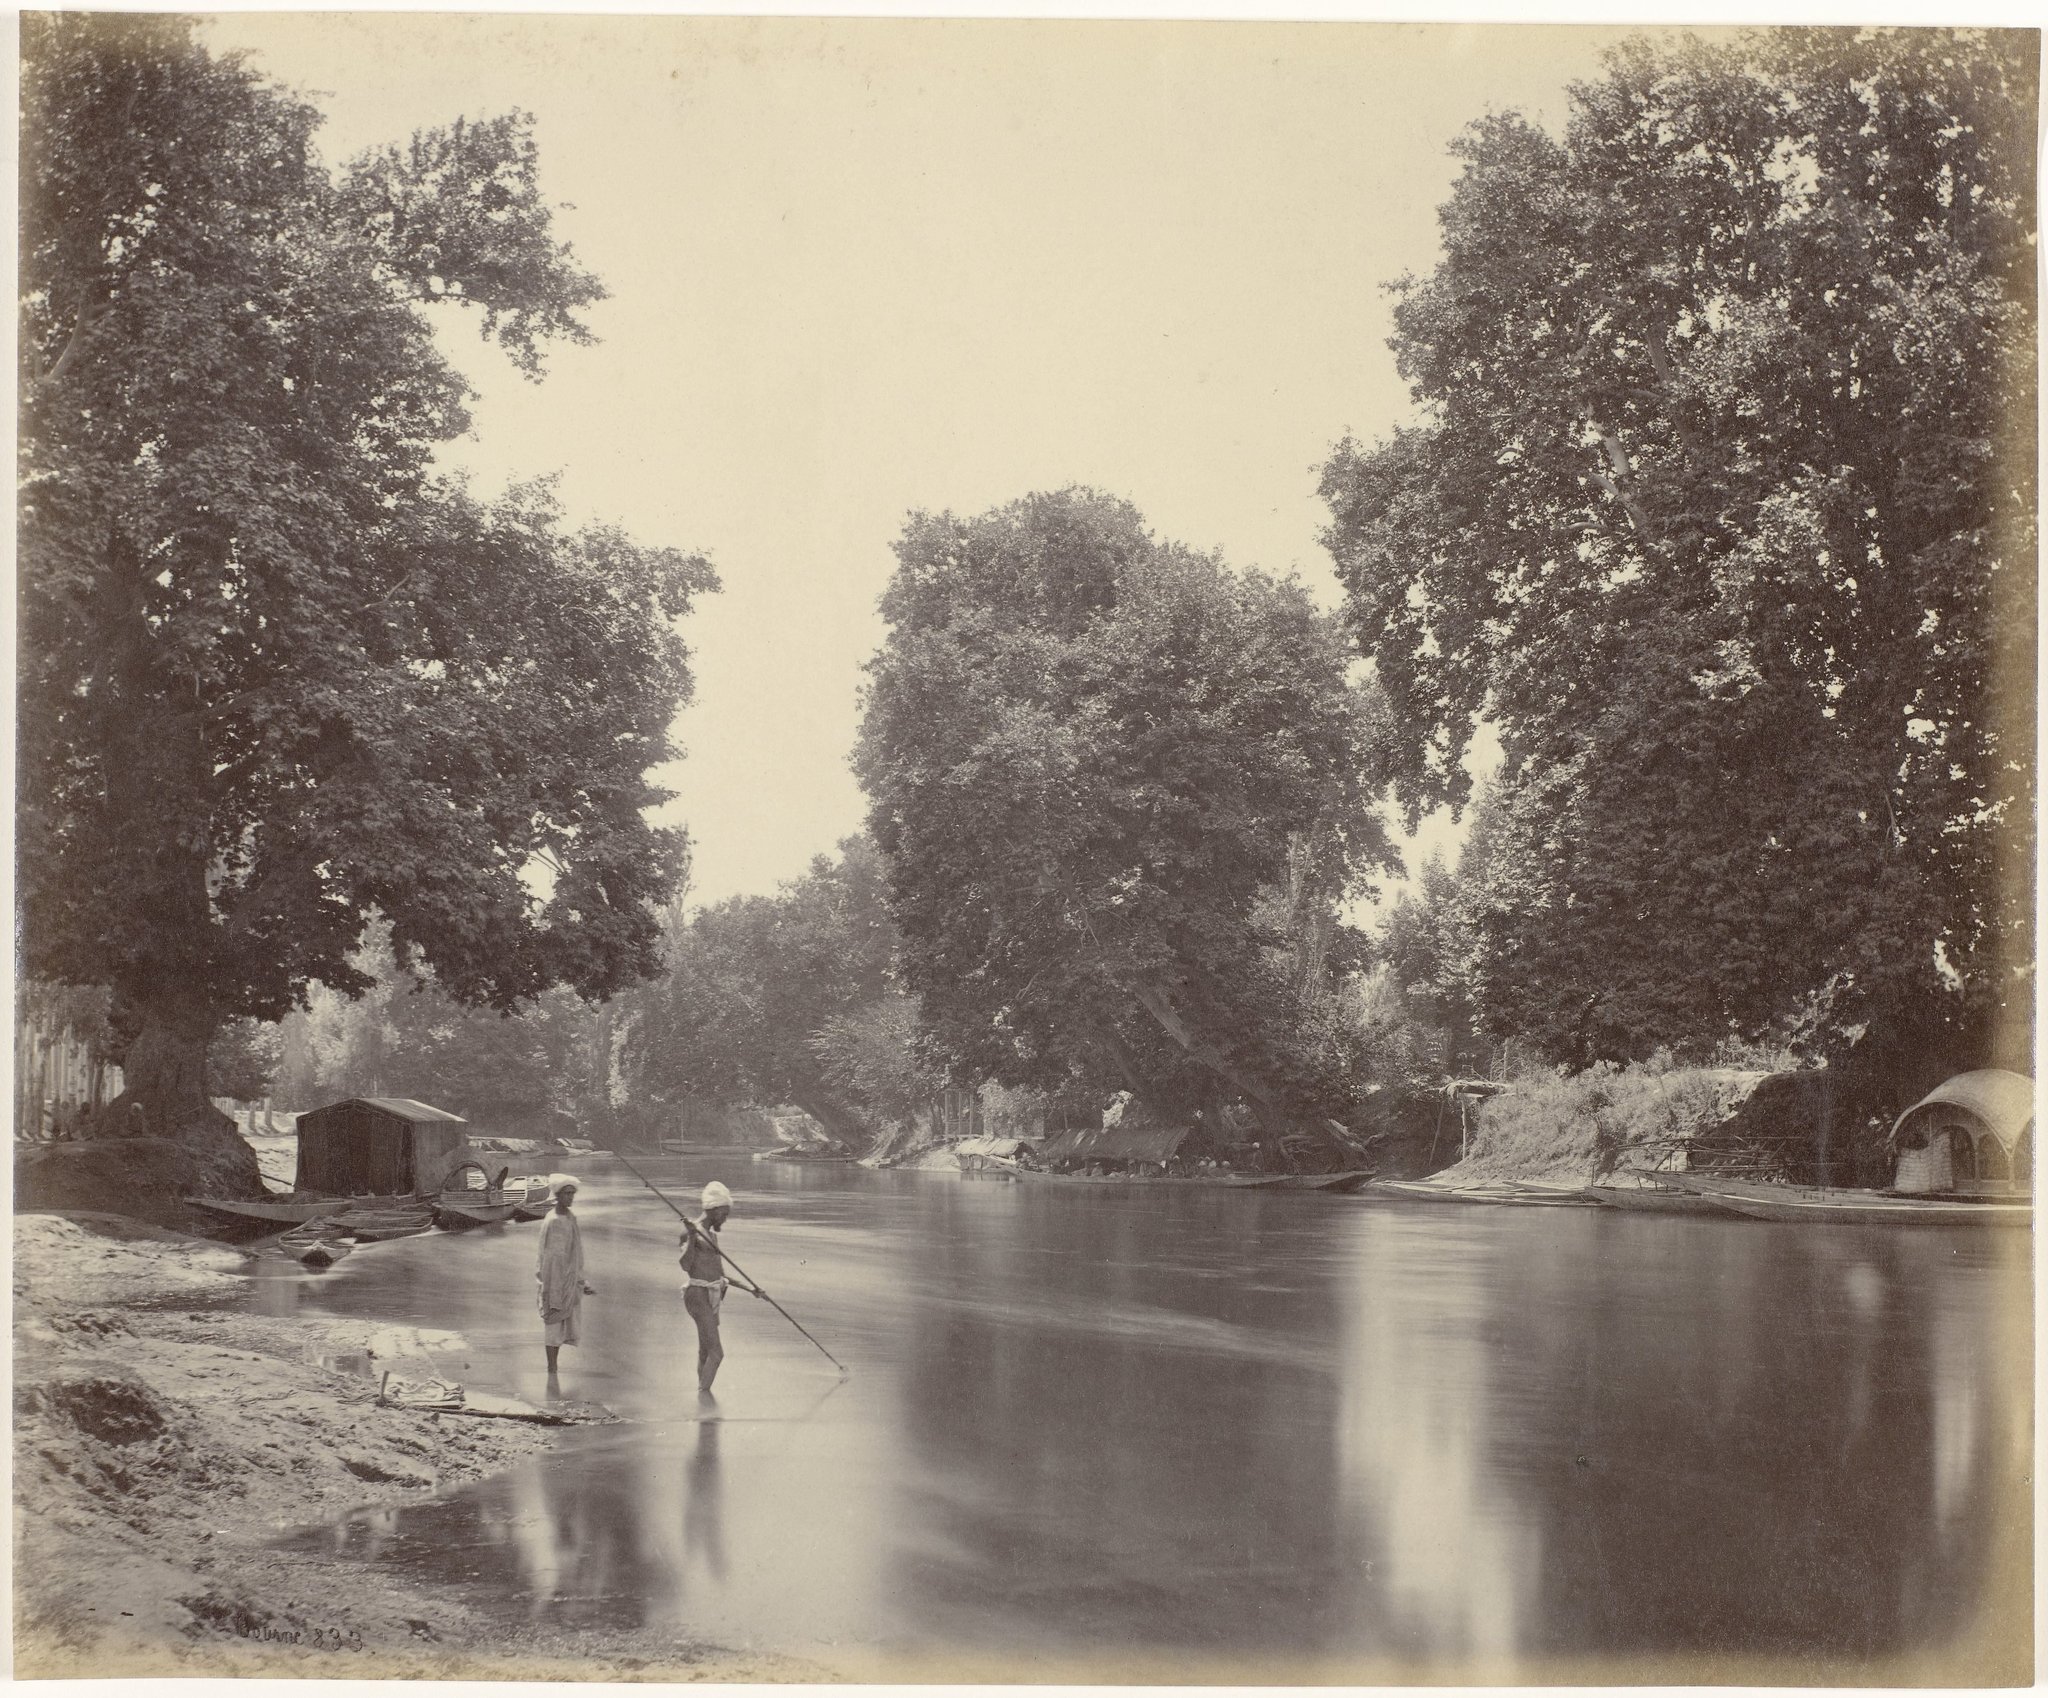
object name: photograph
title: Trees on the Dal lake canal, with two fishermen in the foreground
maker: samuel bourne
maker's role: fotograaf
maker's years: 1834-1912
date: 1864-1865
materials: paper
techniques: albumen print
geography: jammu and kashmir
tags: trees: plane-tree, canal, fisherman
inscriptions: name: ‘Bourne’, number: ‘833’, number: ‘833’